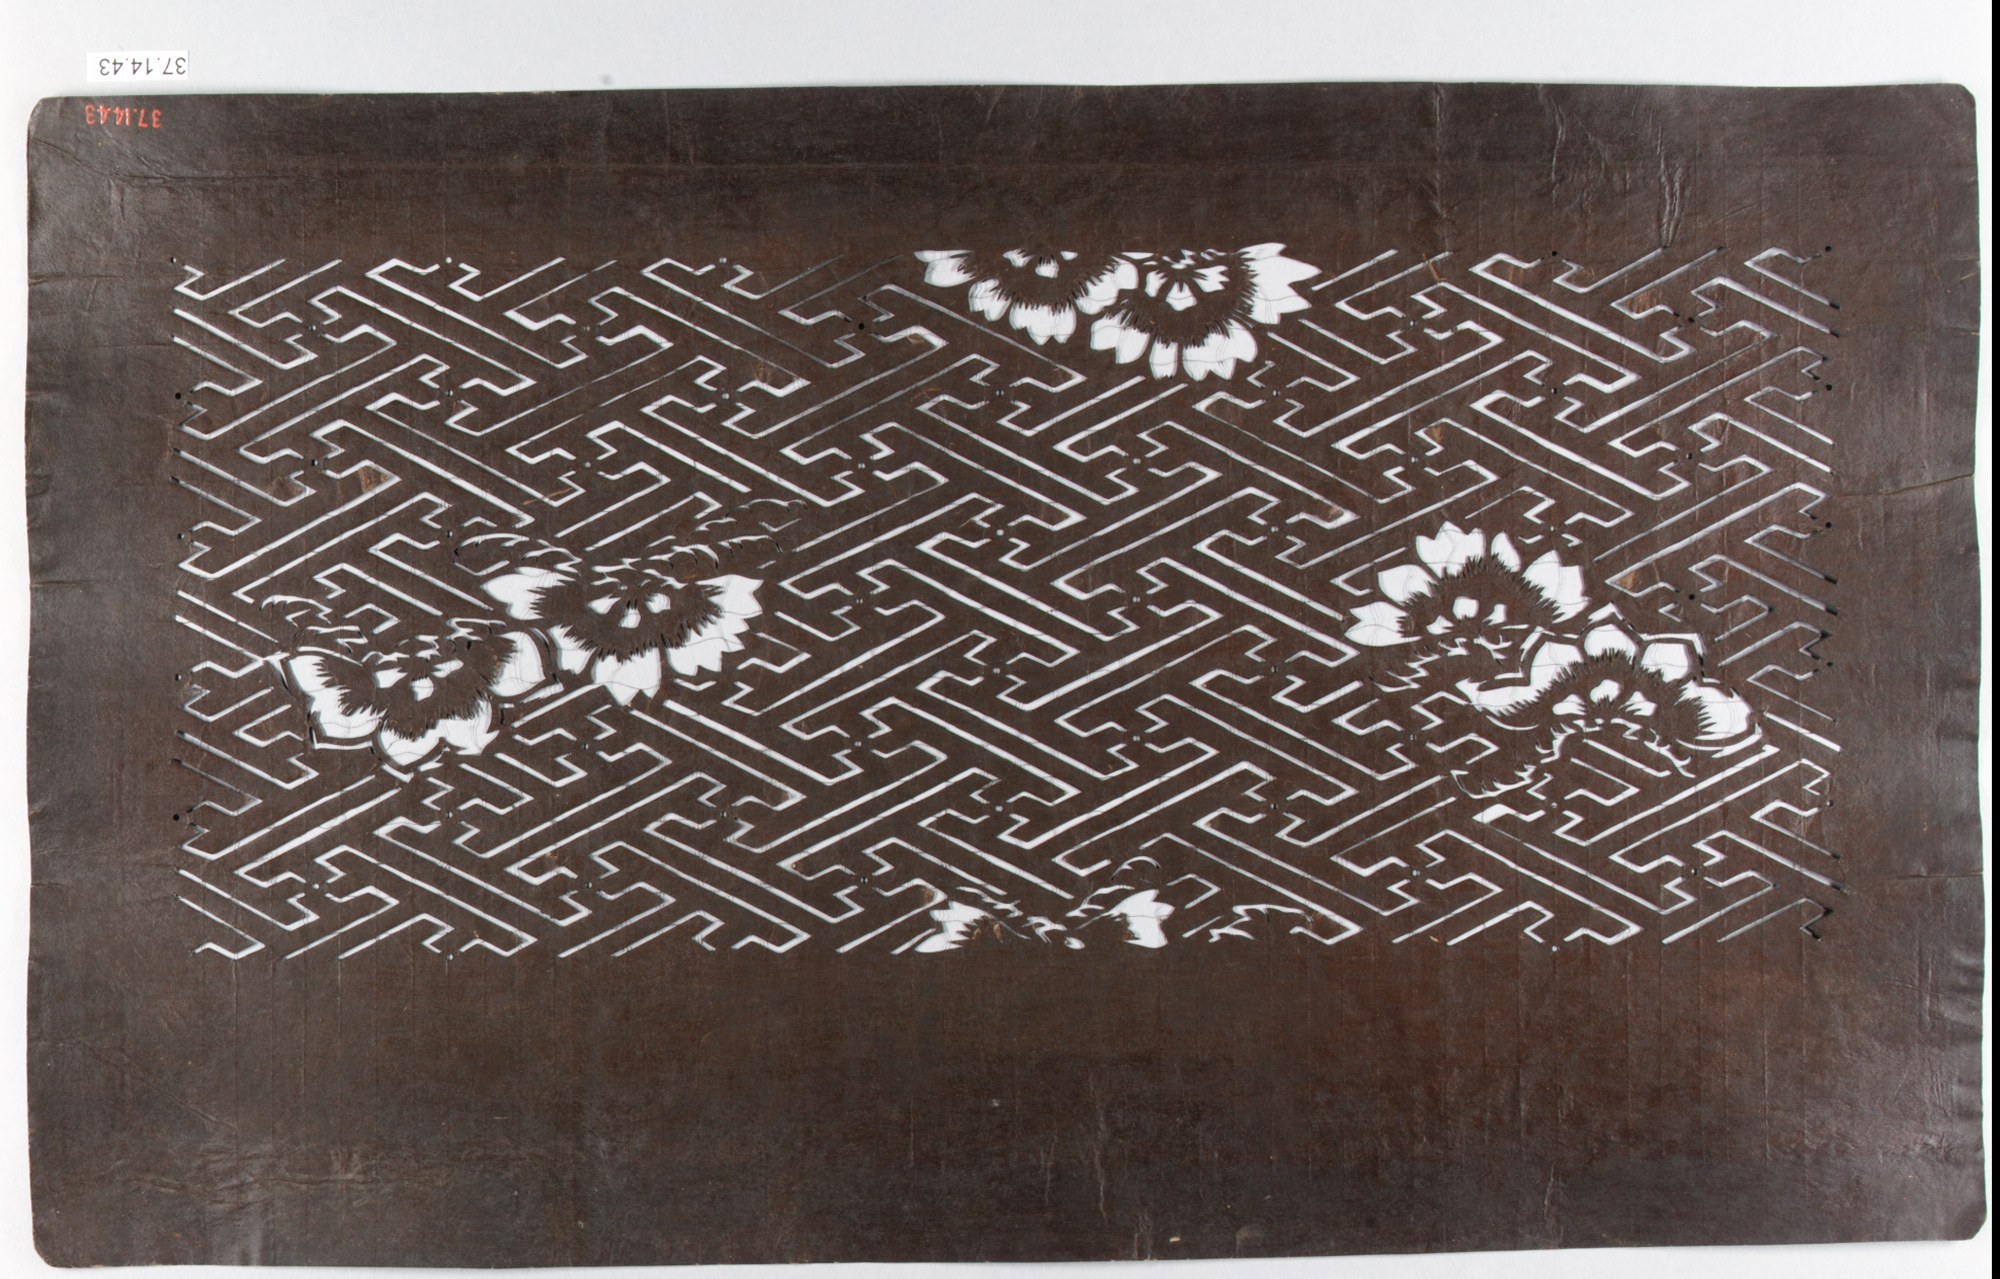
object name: stencil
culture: japanese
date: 1801-1833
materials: paper, silk